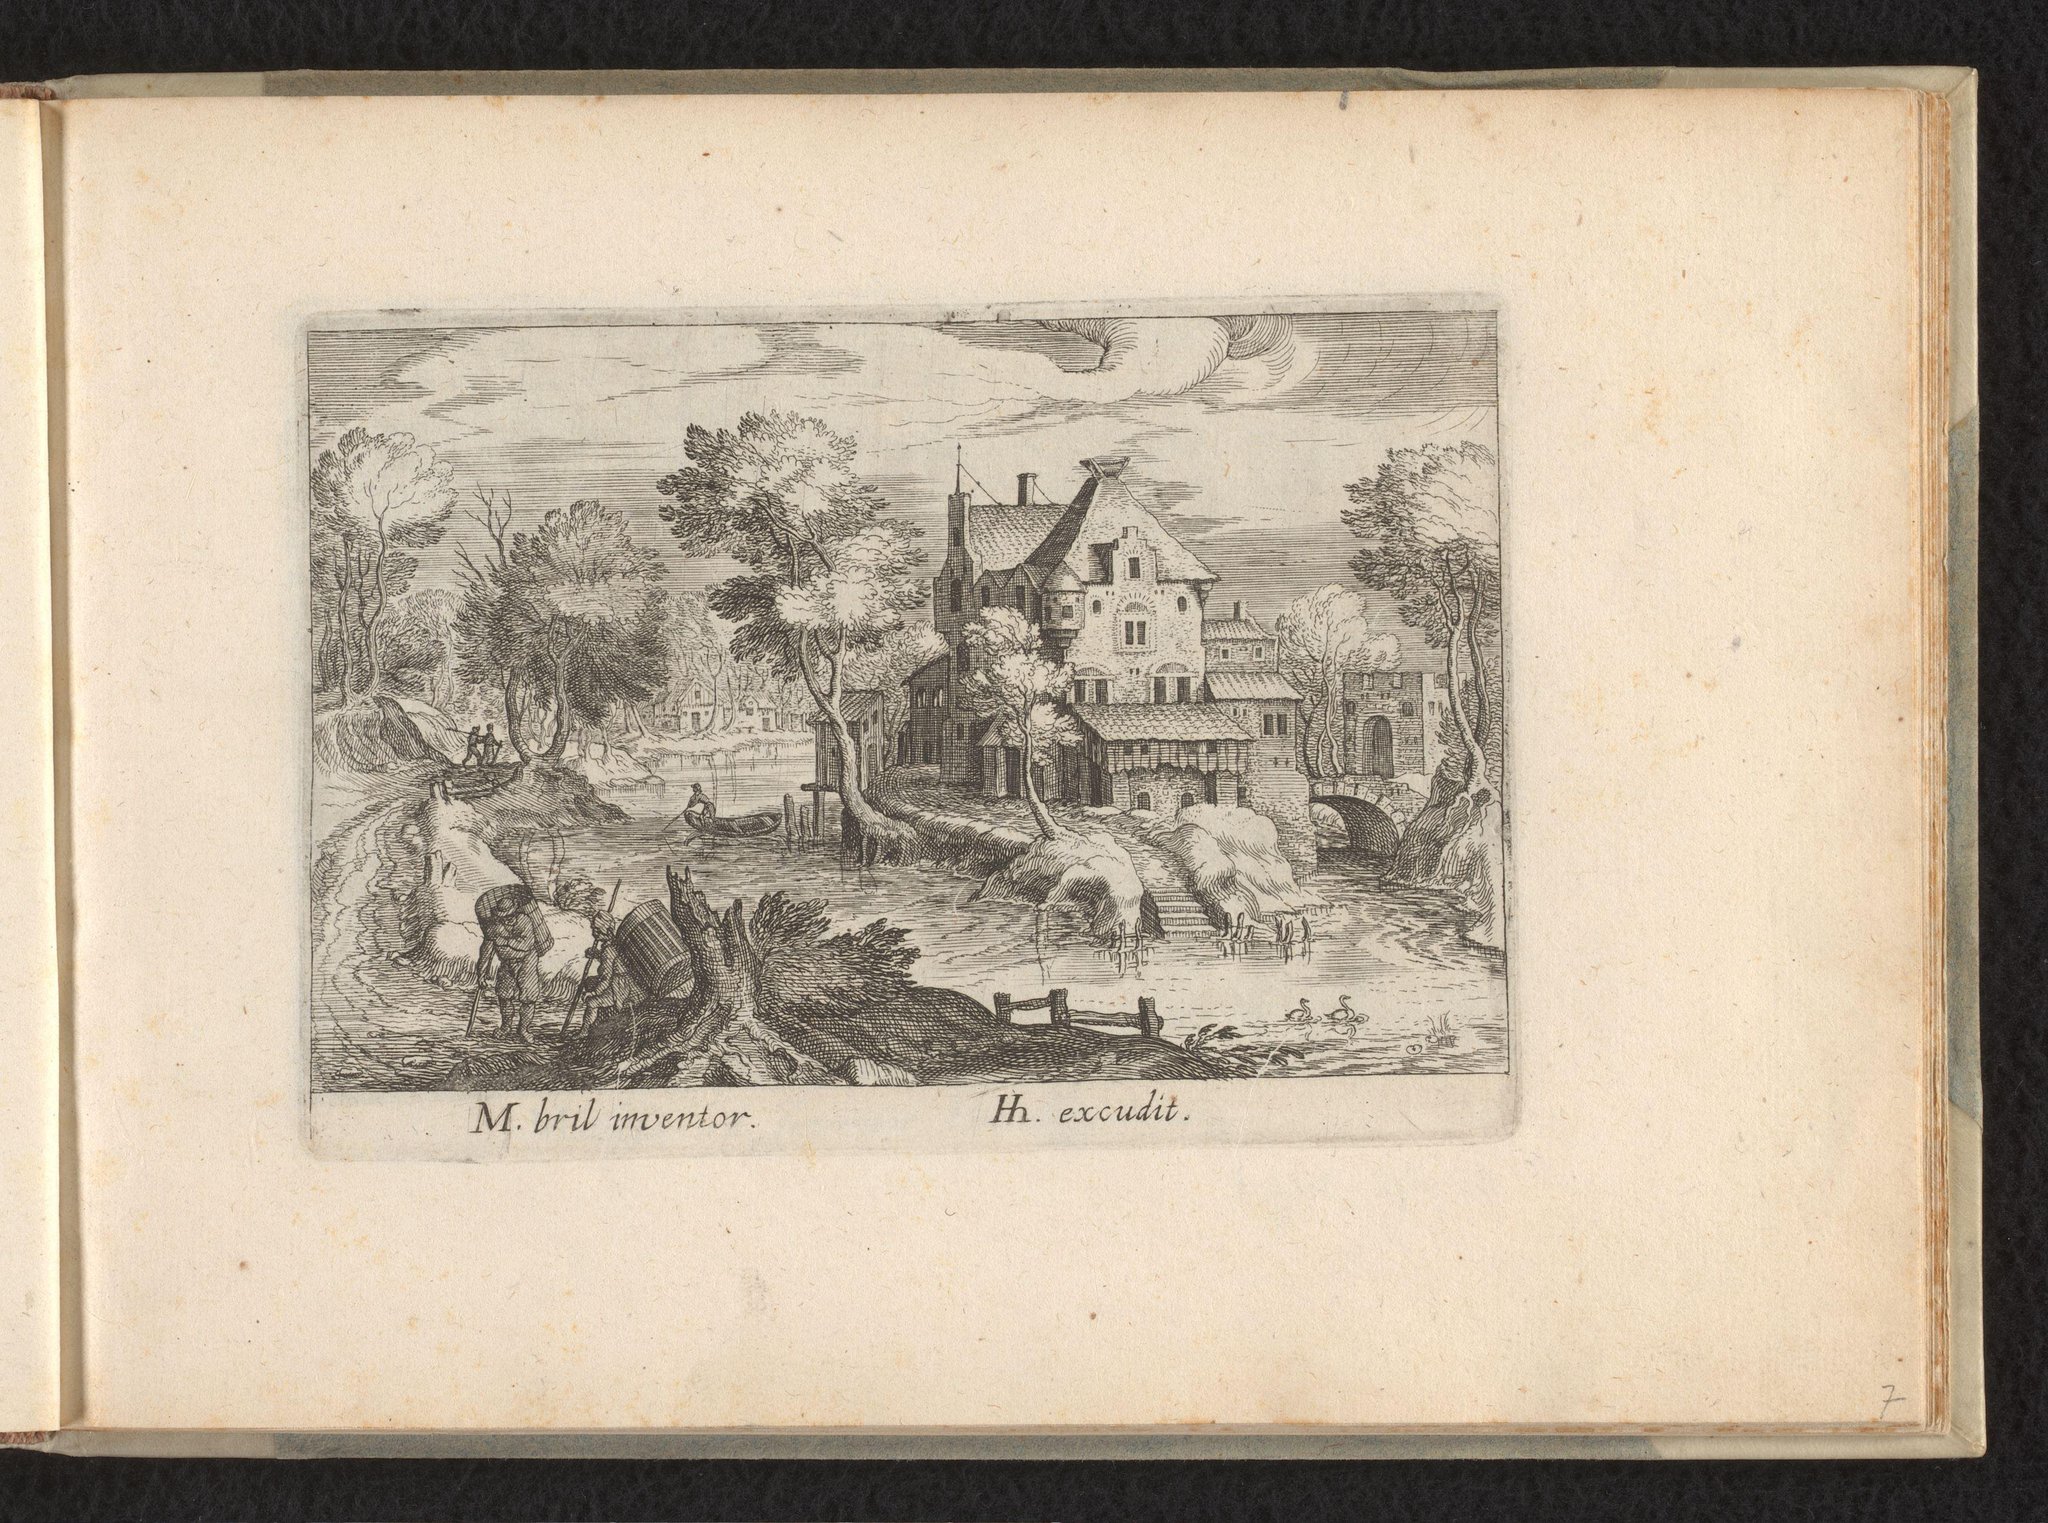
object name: print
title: Rivierlandschap met huis op een eilandje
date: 1614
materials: paper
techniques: etching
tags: carrying something, village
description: Groot huis met bijgebouwen op een eilandje. Links op de voorgrond twee mannen met een kuip (vat) op hun rug. Een roeibootje in het water.